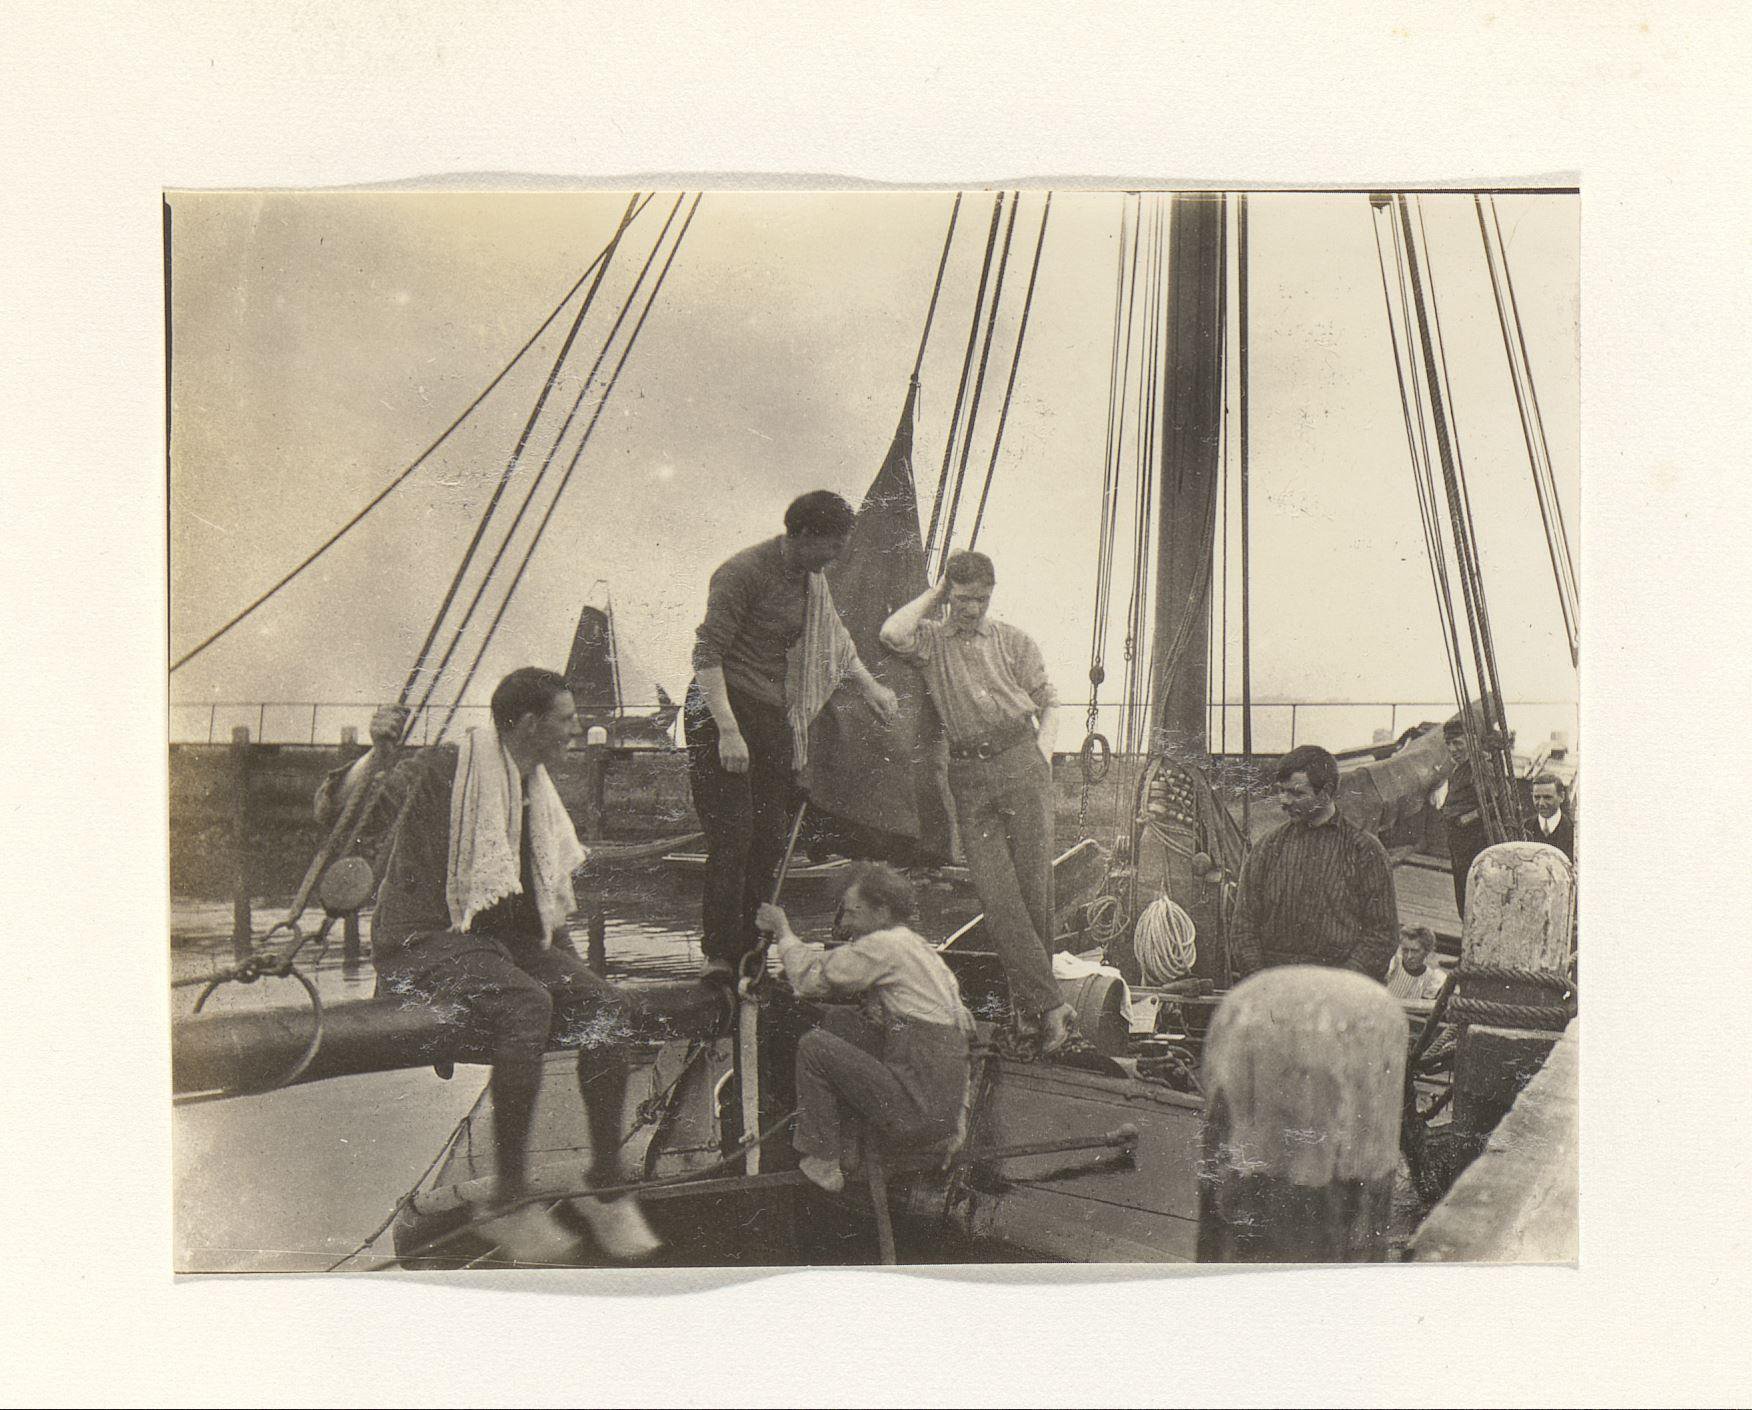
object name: album leaf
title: Mannen op een zeilboot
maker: george hidderley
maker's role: fotograaf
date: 1900-1910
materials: paper, photographic support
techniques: gelatin silver print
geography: volendam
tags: sailing-ship, sailing-boat, adult man, historical persons